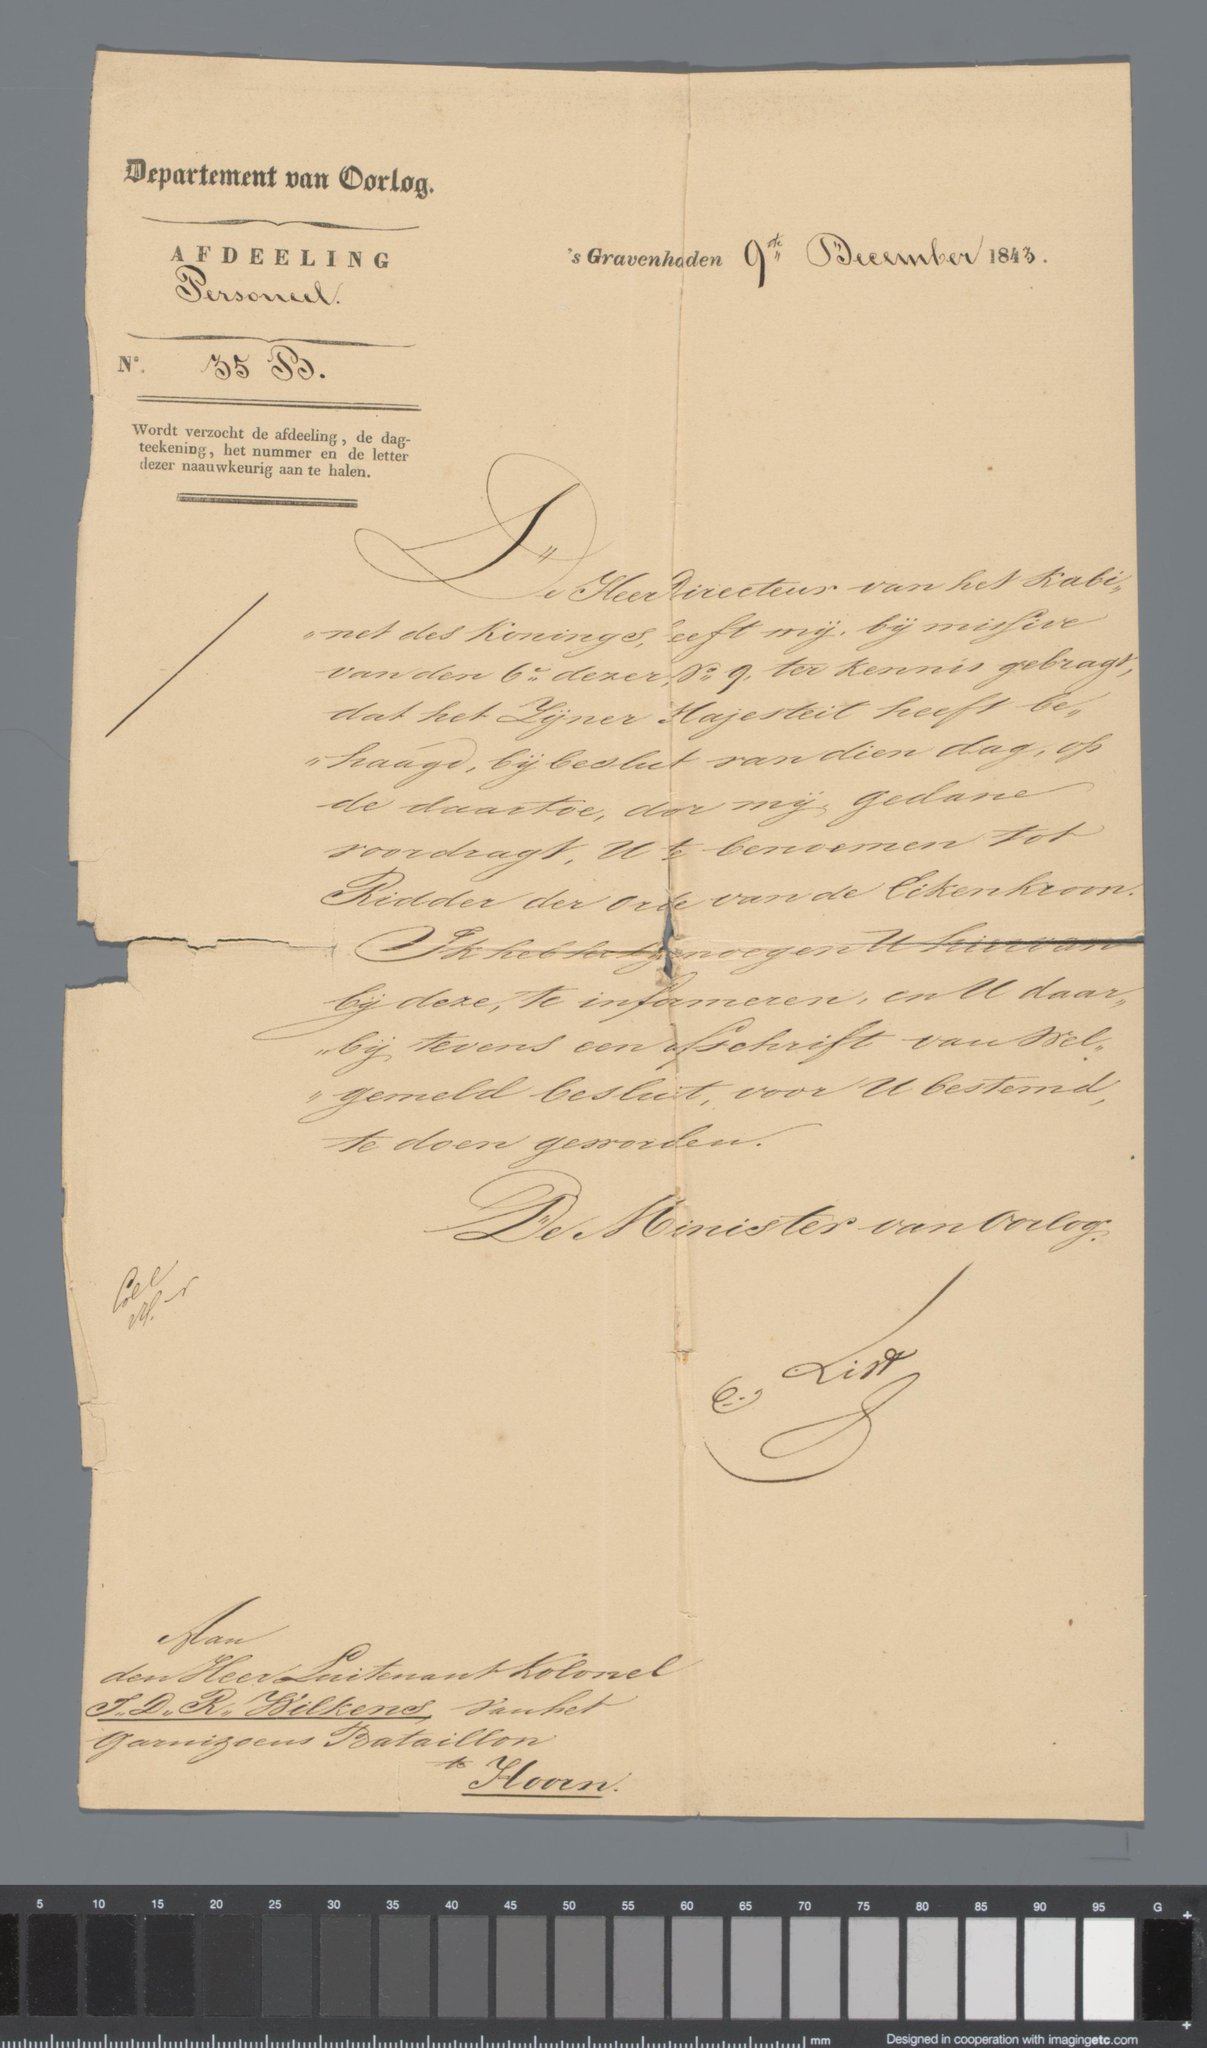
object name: letter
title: Brief van een generaal aan J.D.B. Wilkens over het certificaat, 21 januari 1827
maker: Anonymous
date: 1827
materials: ink, paper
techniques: handwriting, pen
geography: namur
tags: military service, netherlands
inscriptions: number: ‘11198’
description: Onderdeel van een groep van documenten betreffende de staat van dienst, benoemingen, enz. van Luitenant Kolonel van de Infanterie J.D.B. Wilkens. Behorende bij de schenking van het geschilderde portret.